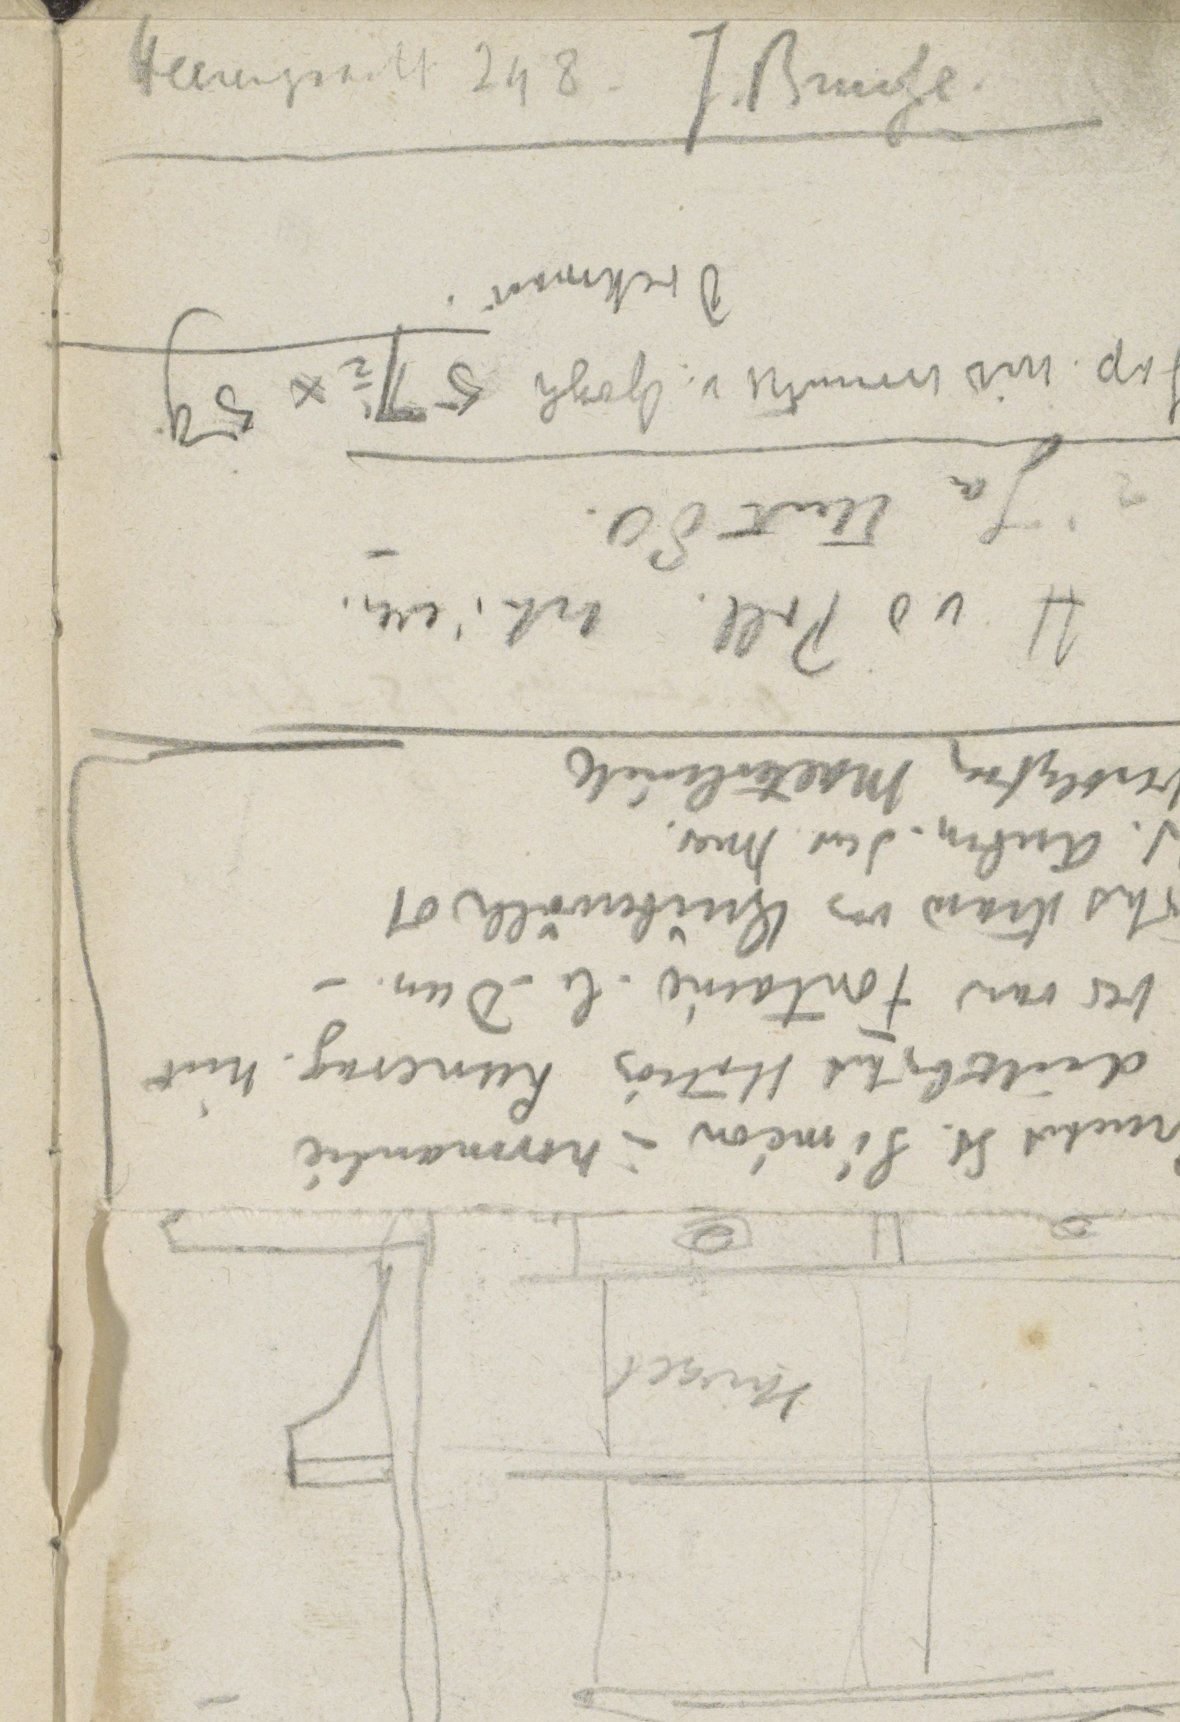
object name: sketchbook leaf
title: Annotaties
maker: george hendrik breitner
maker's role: draughtsman, painter, print maker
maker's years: 1857-1923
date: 1900-1901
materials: chalk, paper, pencil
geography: amsterdam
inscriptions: address: ‘Heerengracht 248 J. Brusse[?]’, annotation: ‘Jap. wit [...] v. Gogh [afmetingen]’, annotation: ‘Gruchet St. Siméon in Normandie/ dichtbij het station Luneray. Niet/ ver van Fontaine-le-Dun.-/ bij[...] strand van Quiberville of/ St. Aubin-sur-Mer,/ verblijf[...] Maeterlinck’, annotation: ‘H. v.d. Poll [...]’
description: Aantekeningen. Pagina 90 uit een schetsboek met 46 bladen vervaardigd te Amsterdam.